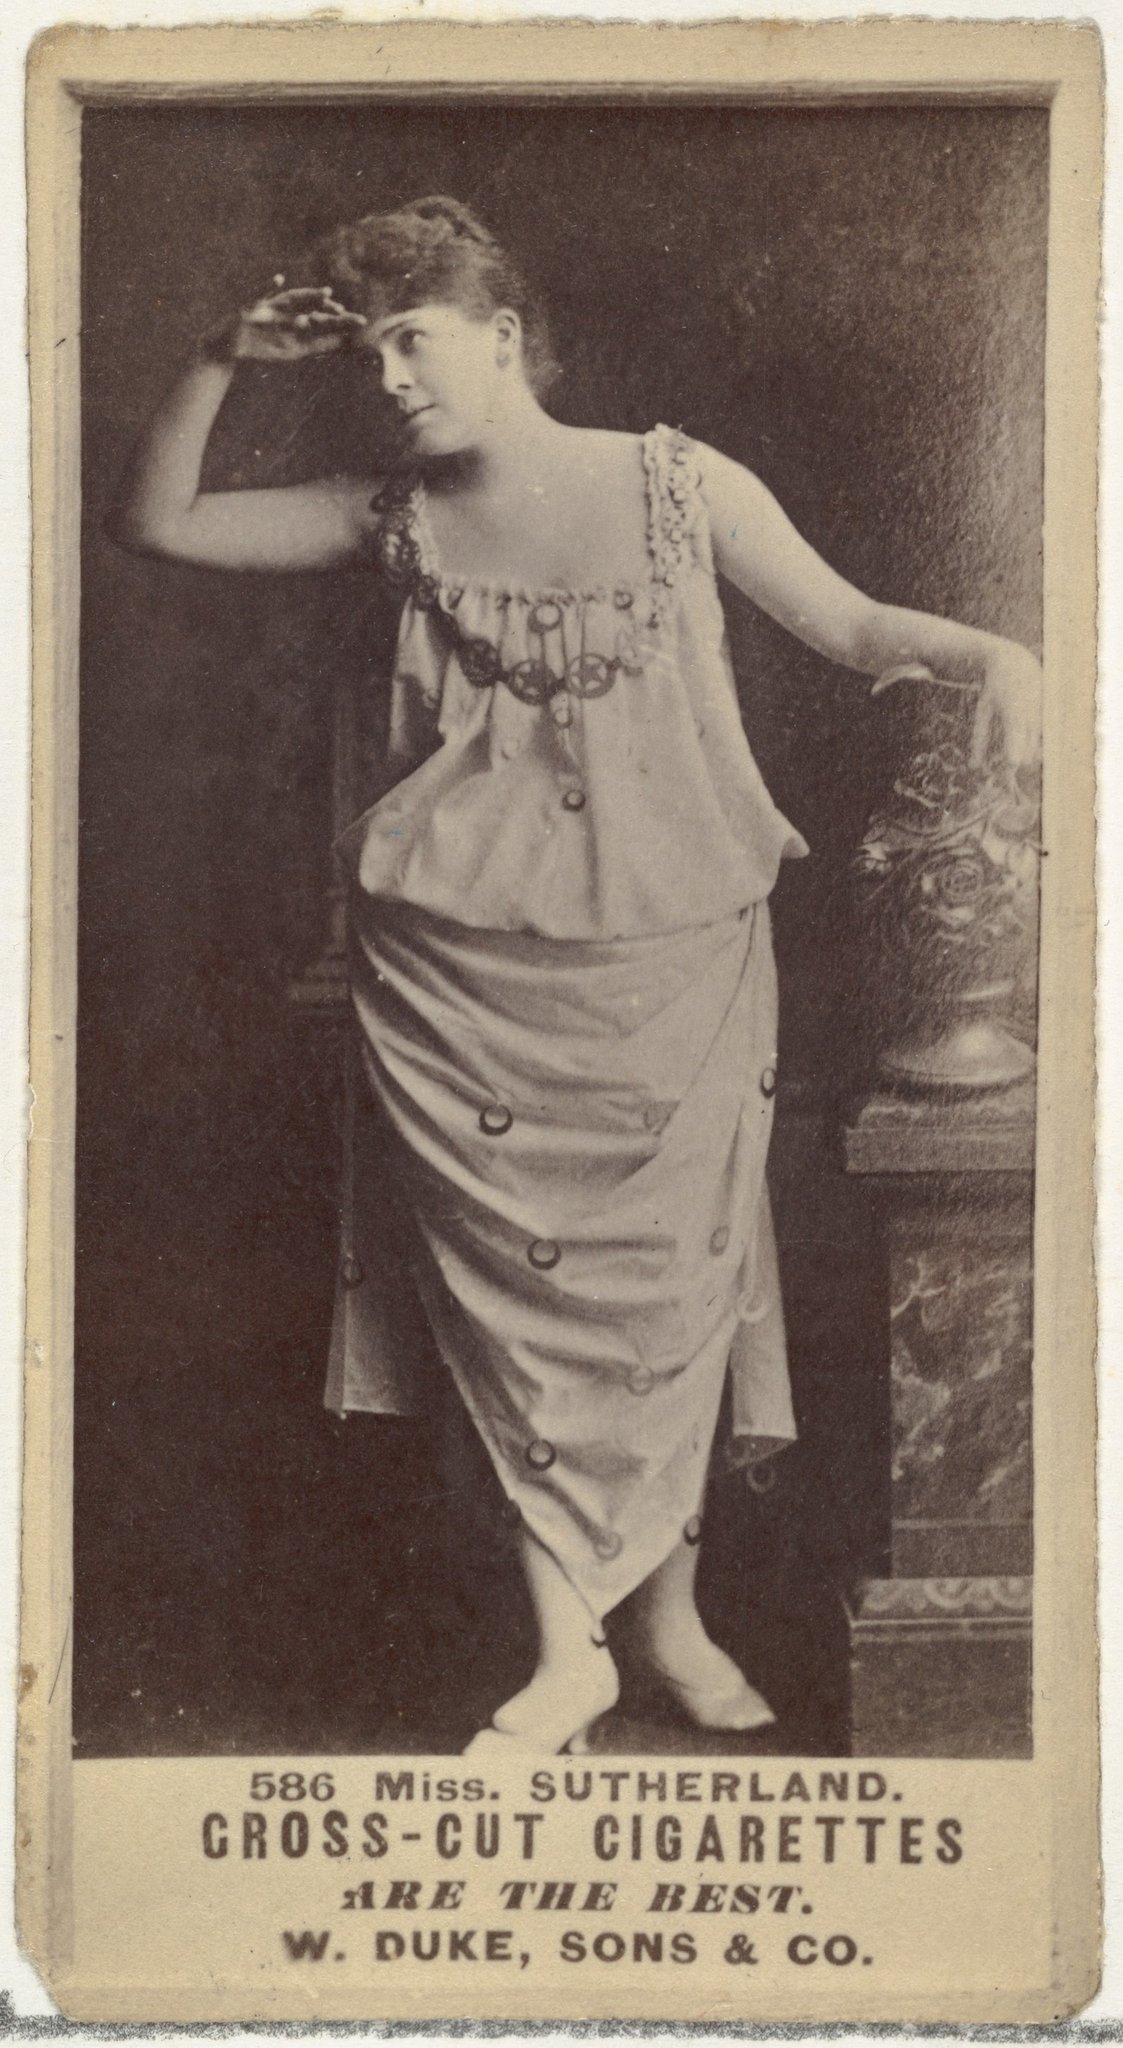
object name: photograph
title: Card Number 586, Miss Sutherland, from the Actors and Actresses series (N145-3) issued by Duke Sons & Co. to promote Cross Cut Cigarettes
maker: w. duke, sons & co.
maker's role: publisher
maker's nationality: american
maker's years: 1870-1920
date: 1880-1889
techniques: albumen silver print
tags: portraits,women,actresses